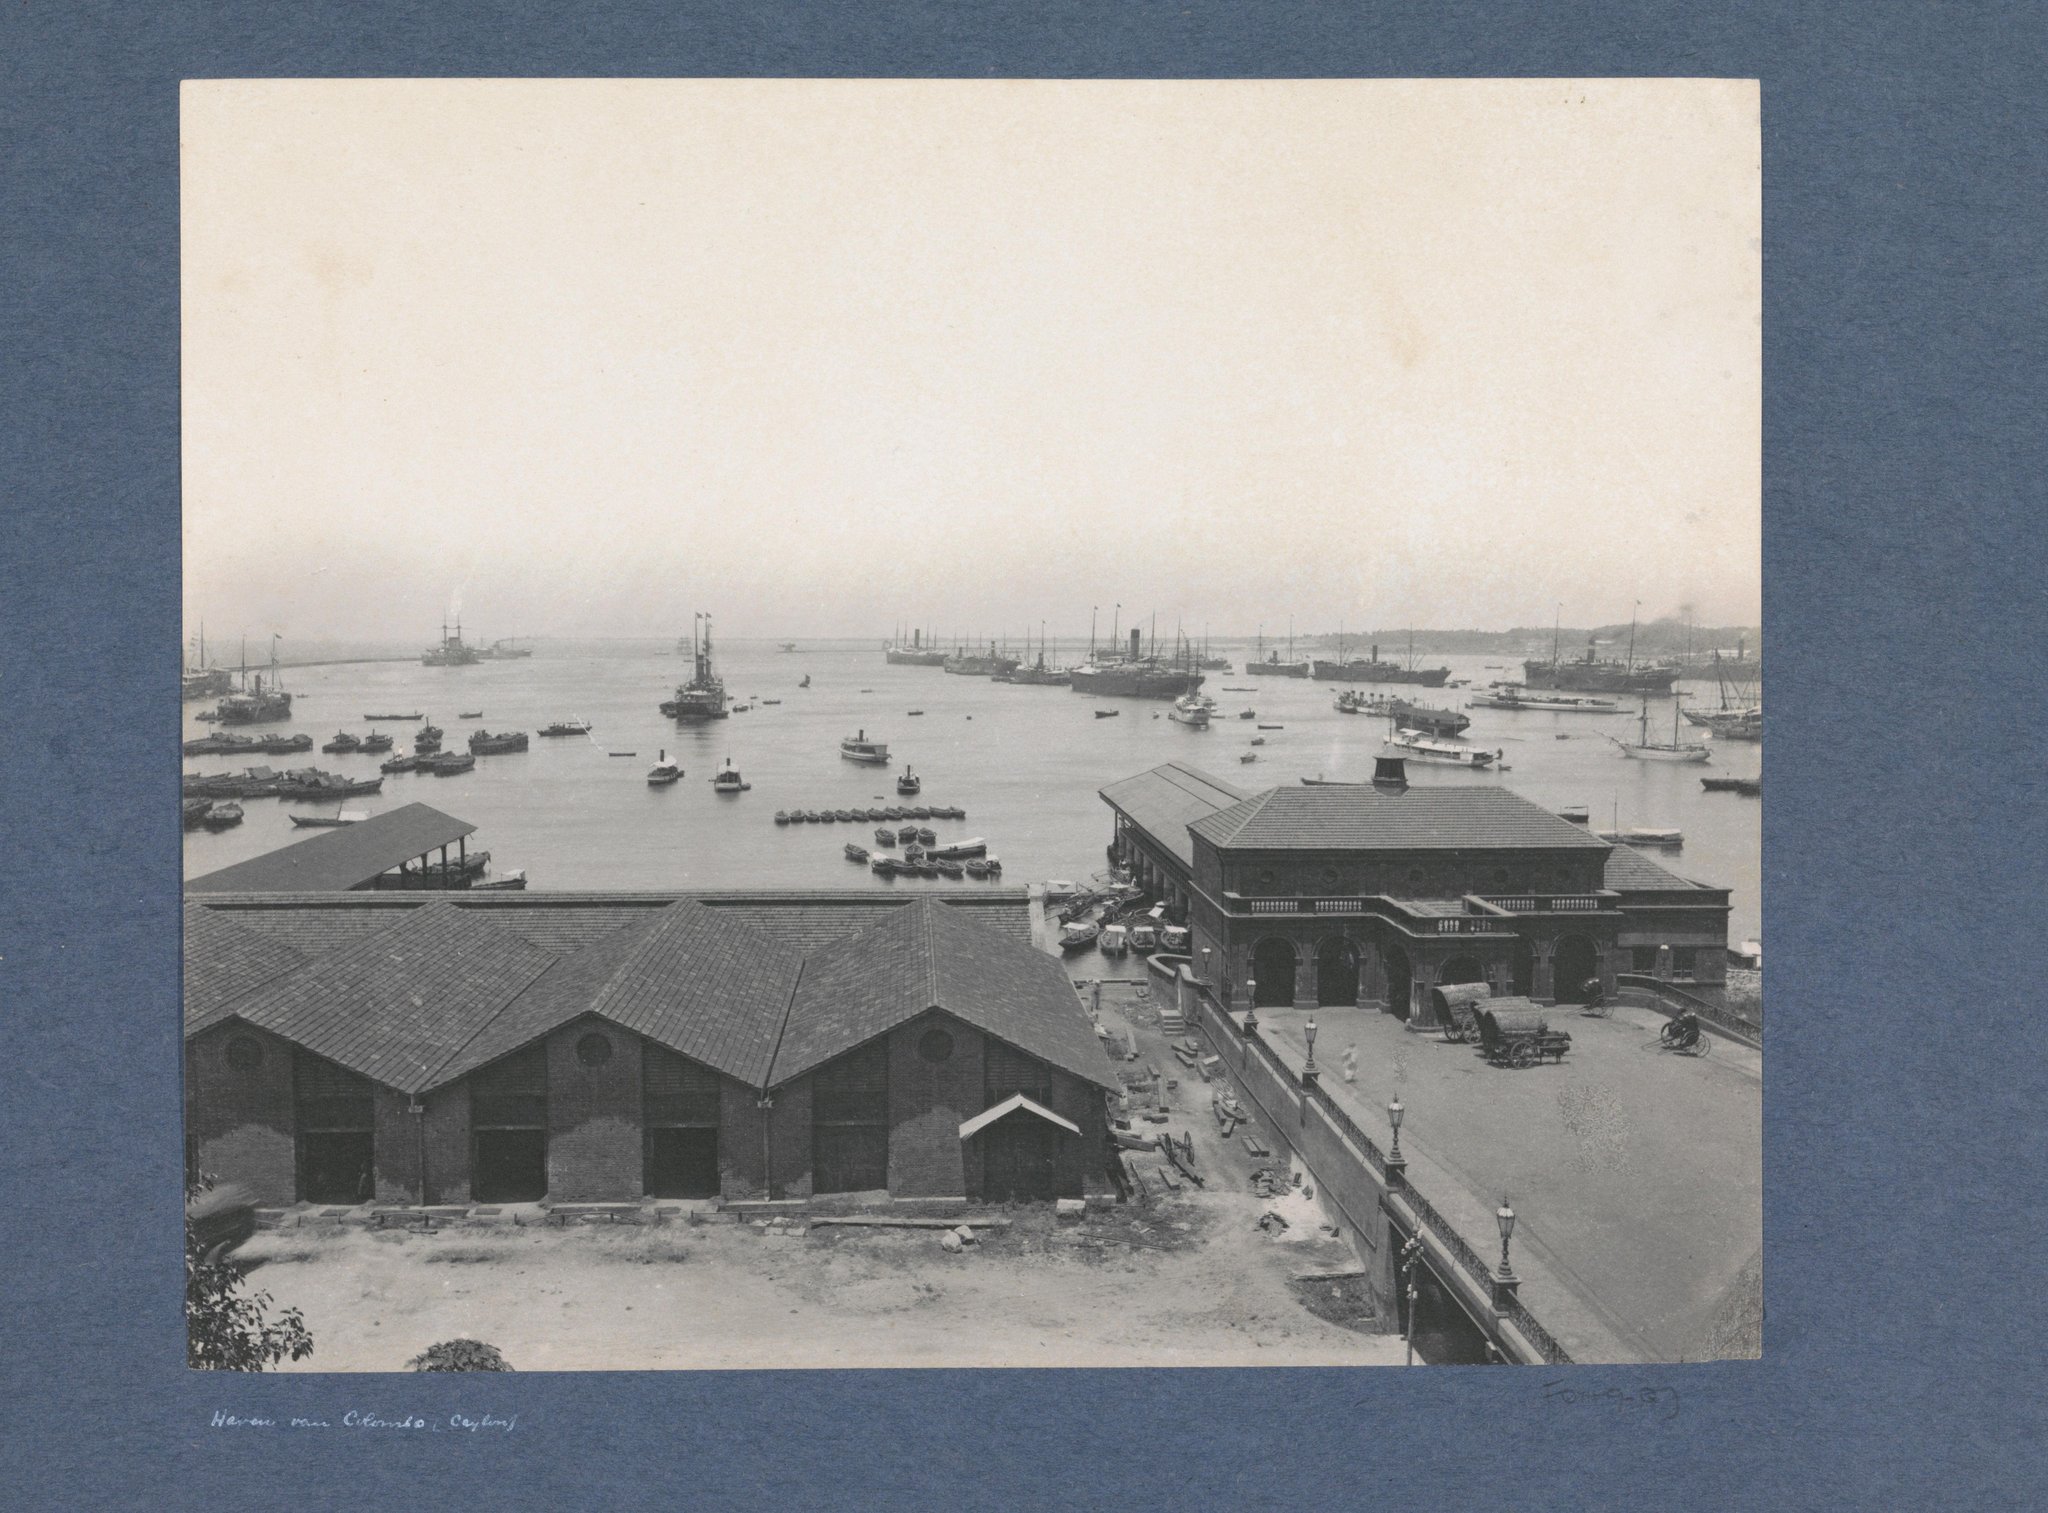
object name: photograph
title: View of Colombo Harbour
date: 1900-1920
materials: paper, photographic support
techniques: platinum process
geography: colombo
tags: warehouse (~ harbour), harbour (+ view ~ vehicle, ship, etc.)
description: Onderdeel van reisalbum met foto's van bedrijvigheid en bezienswaardigheden op Sumatra en Java en van de reis naar en van Nederlands-Indië.